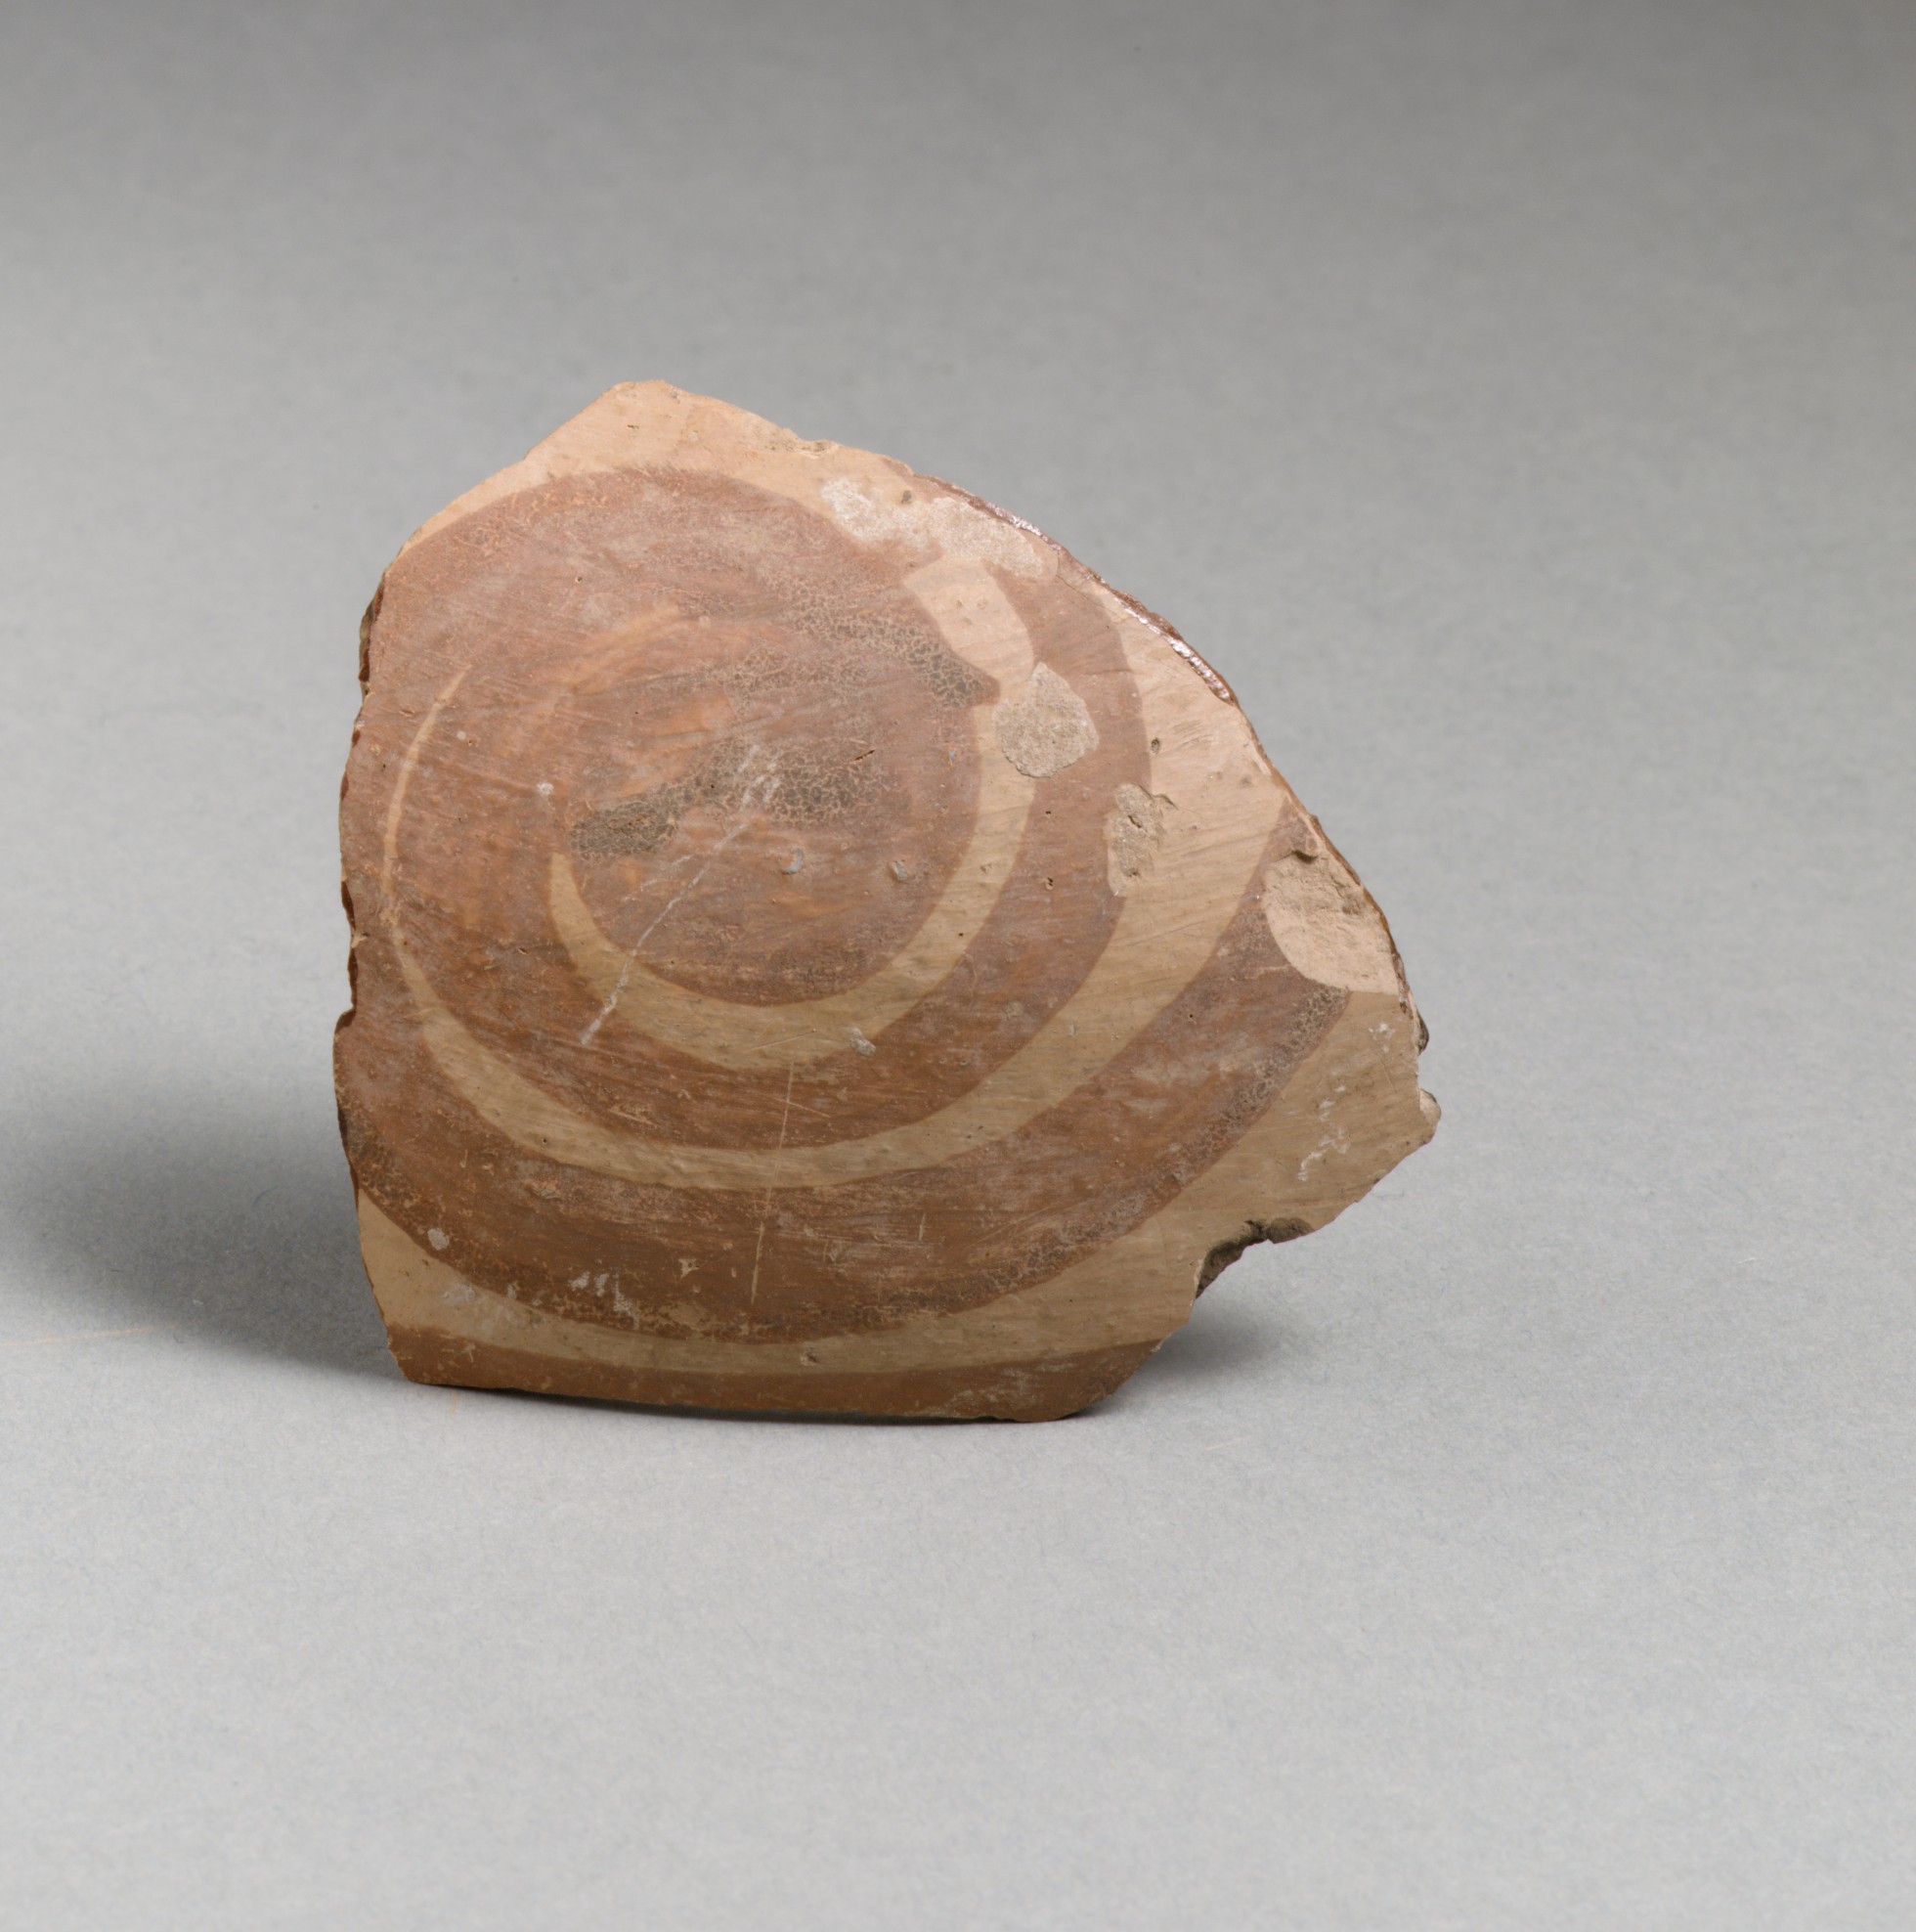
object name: vase fragment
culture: minoan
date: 1600-1450 BCE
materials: terracotta